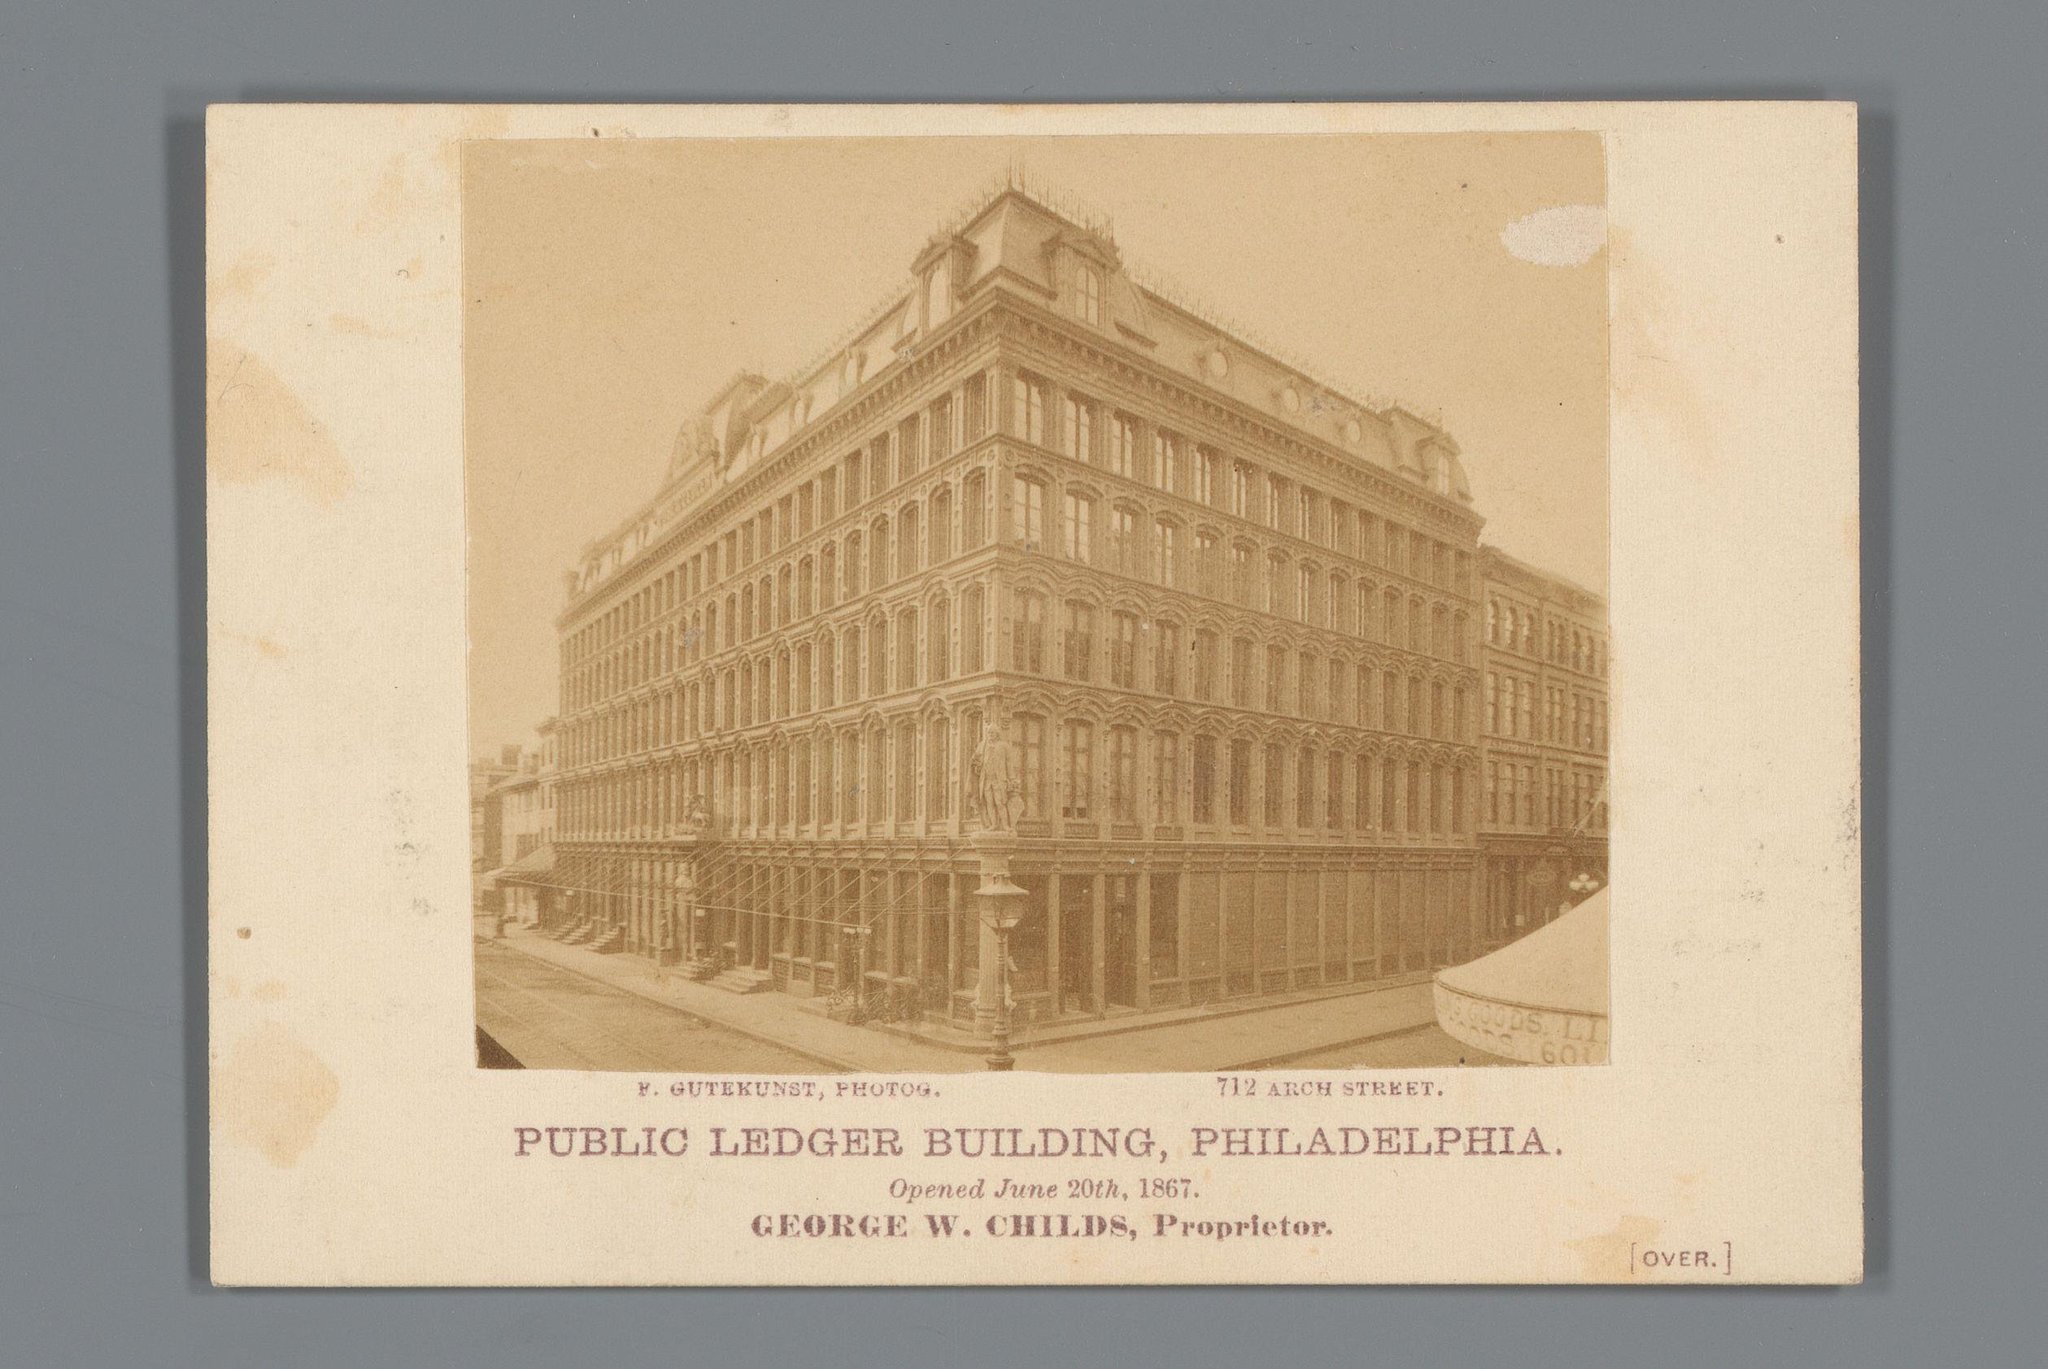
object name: photograph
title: Reclame voor het Amerikaanse blad Public Ledger met gezicht op de uitgeverij in Philadelphia, Pennsylvania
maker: frederick gutekunst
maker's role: fotograaf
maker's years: 1831-1917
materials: cardboard, photographic support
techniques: albumen print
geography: philadelphia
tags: advertising, press, journalism, publishing, publisher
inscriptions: inscription: ‘(...)’, inscription: ‘F. GUTEKUNST, PHOTOG. 712 ARCH STREET./ (...)’